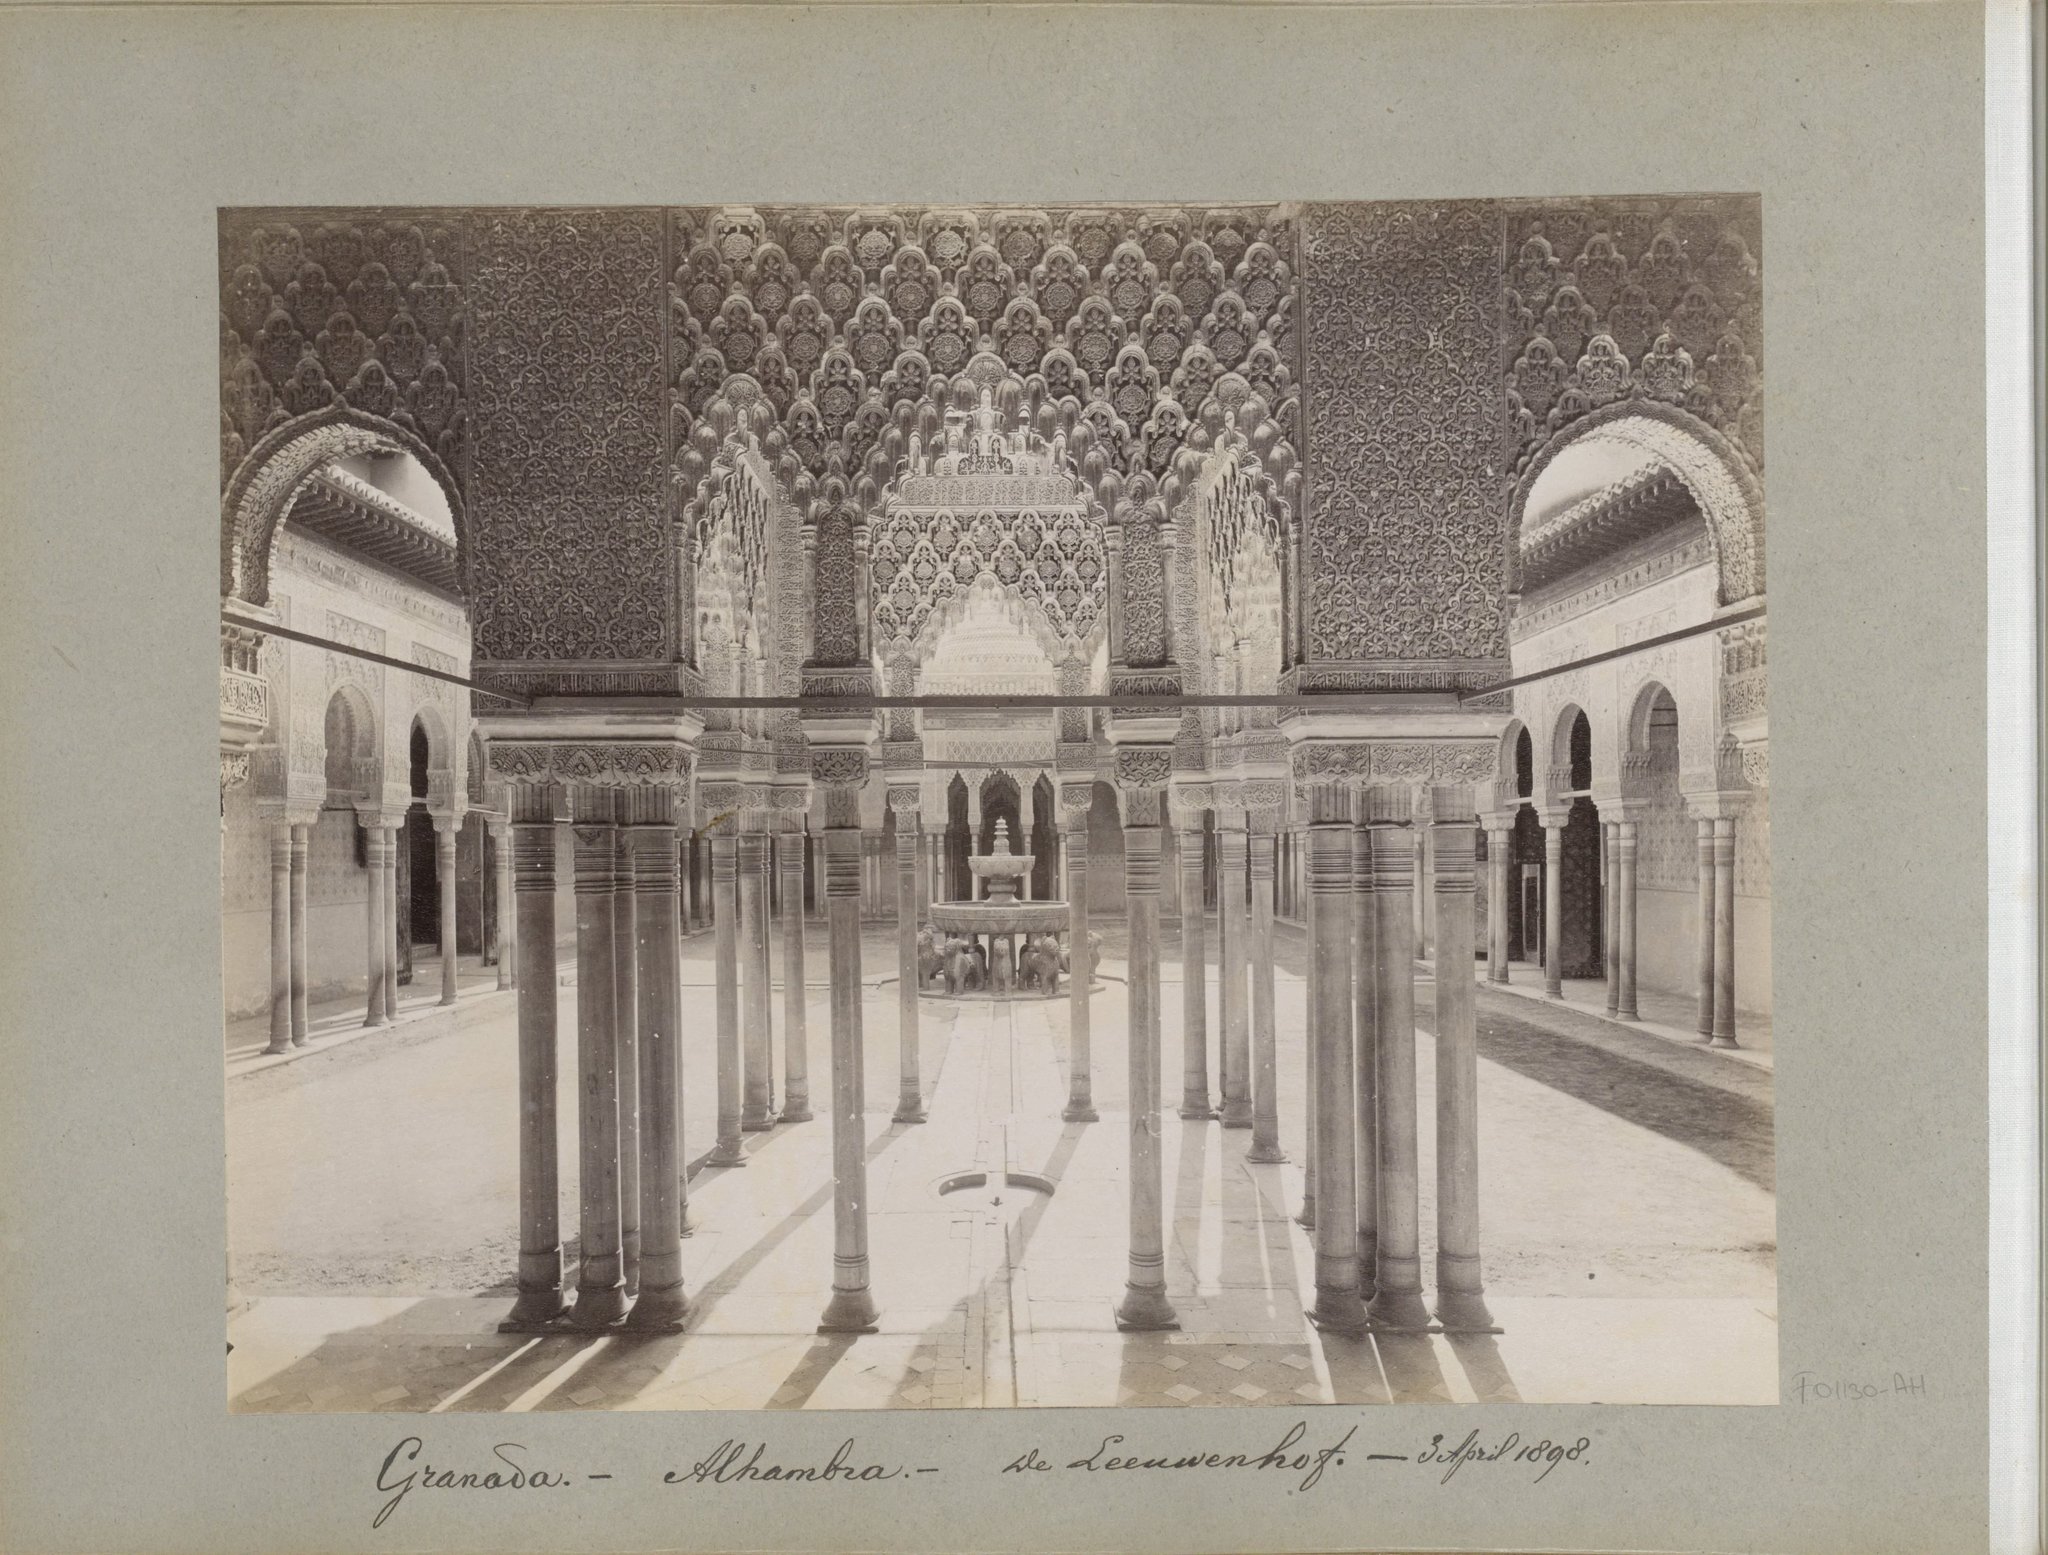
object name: photograph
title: GRANADA. Alhambra. Patio de los Leones desde el templete de Poniente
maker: rafael garzón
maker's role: publisher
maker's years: 1863-1923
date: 1880-1898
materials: paper, photographic support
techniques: albumen print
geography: alhambra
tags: ornamental fountain, inner court of palace or 'hôtel'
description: Onderdeel van Reisalbum met foto's van bezienswaardigheden in Frankrijk, Spanje, Italië, Duitsland, Zwitserland en Oostenrijk.